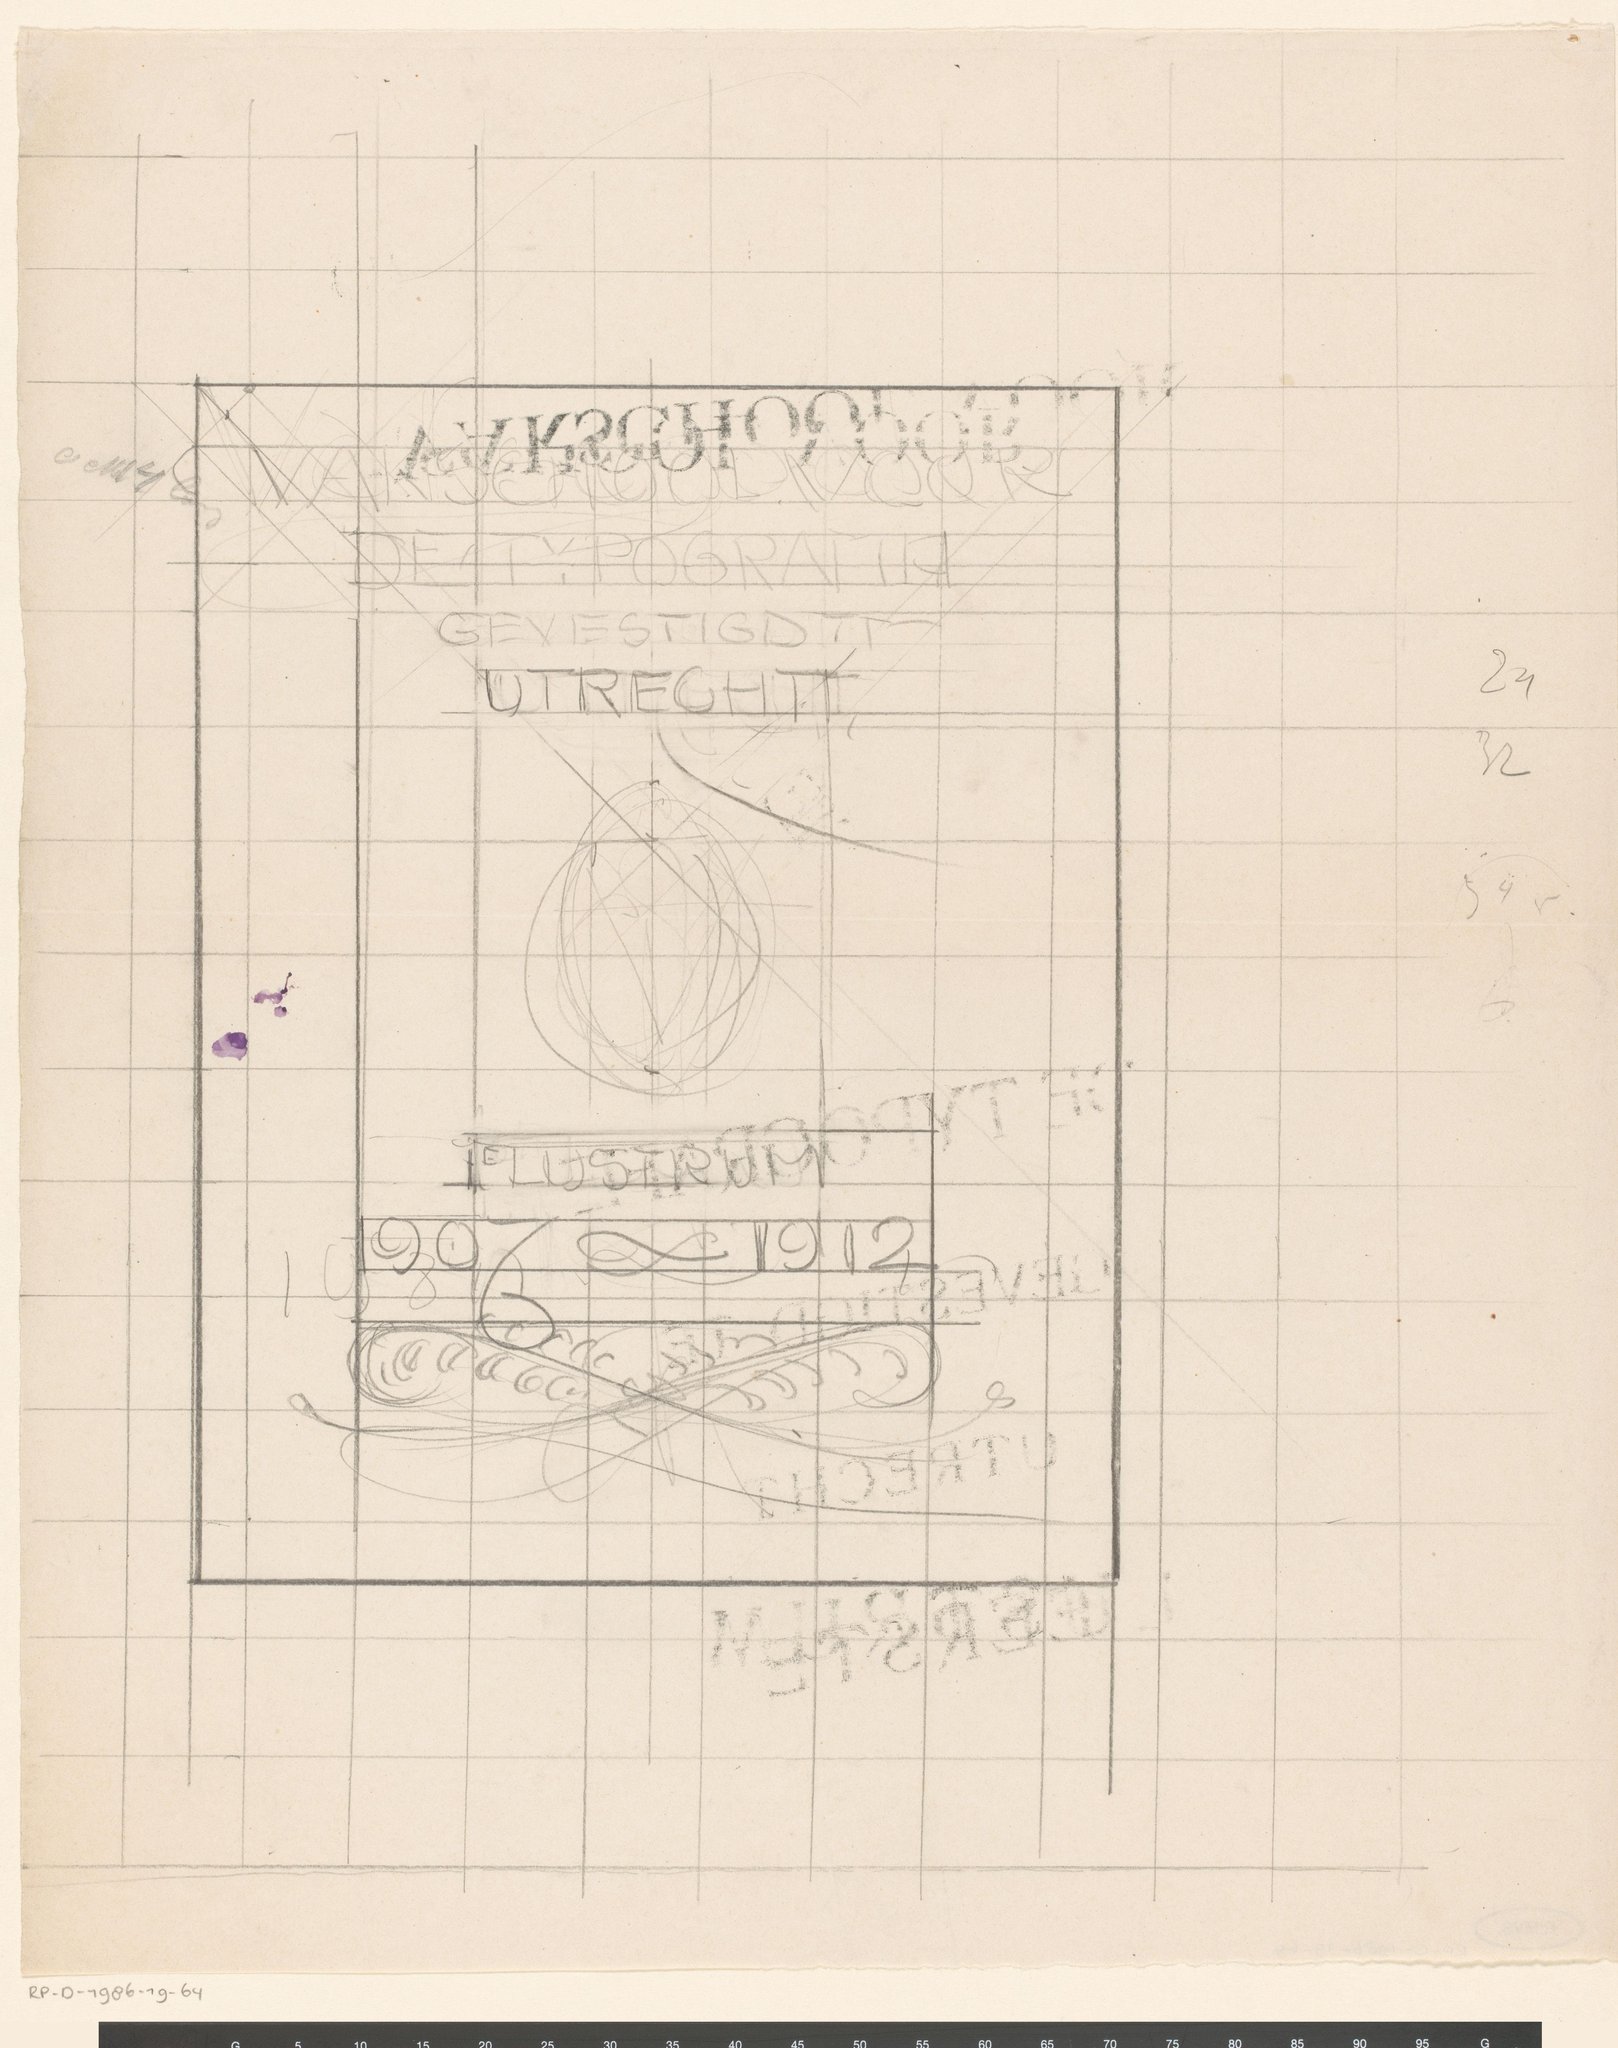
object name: design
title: Ontwerp voor het lustrumboek van de Vakschool voor de typografie te Utrecht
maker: reinier willem petrus de vries (1874-1953)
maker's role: draughtsman, print maker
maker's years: 1874-1953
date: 1912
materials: paper, pencil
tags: vakschool voor de typografie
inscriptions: collector's mark: ‘R:MVS.’